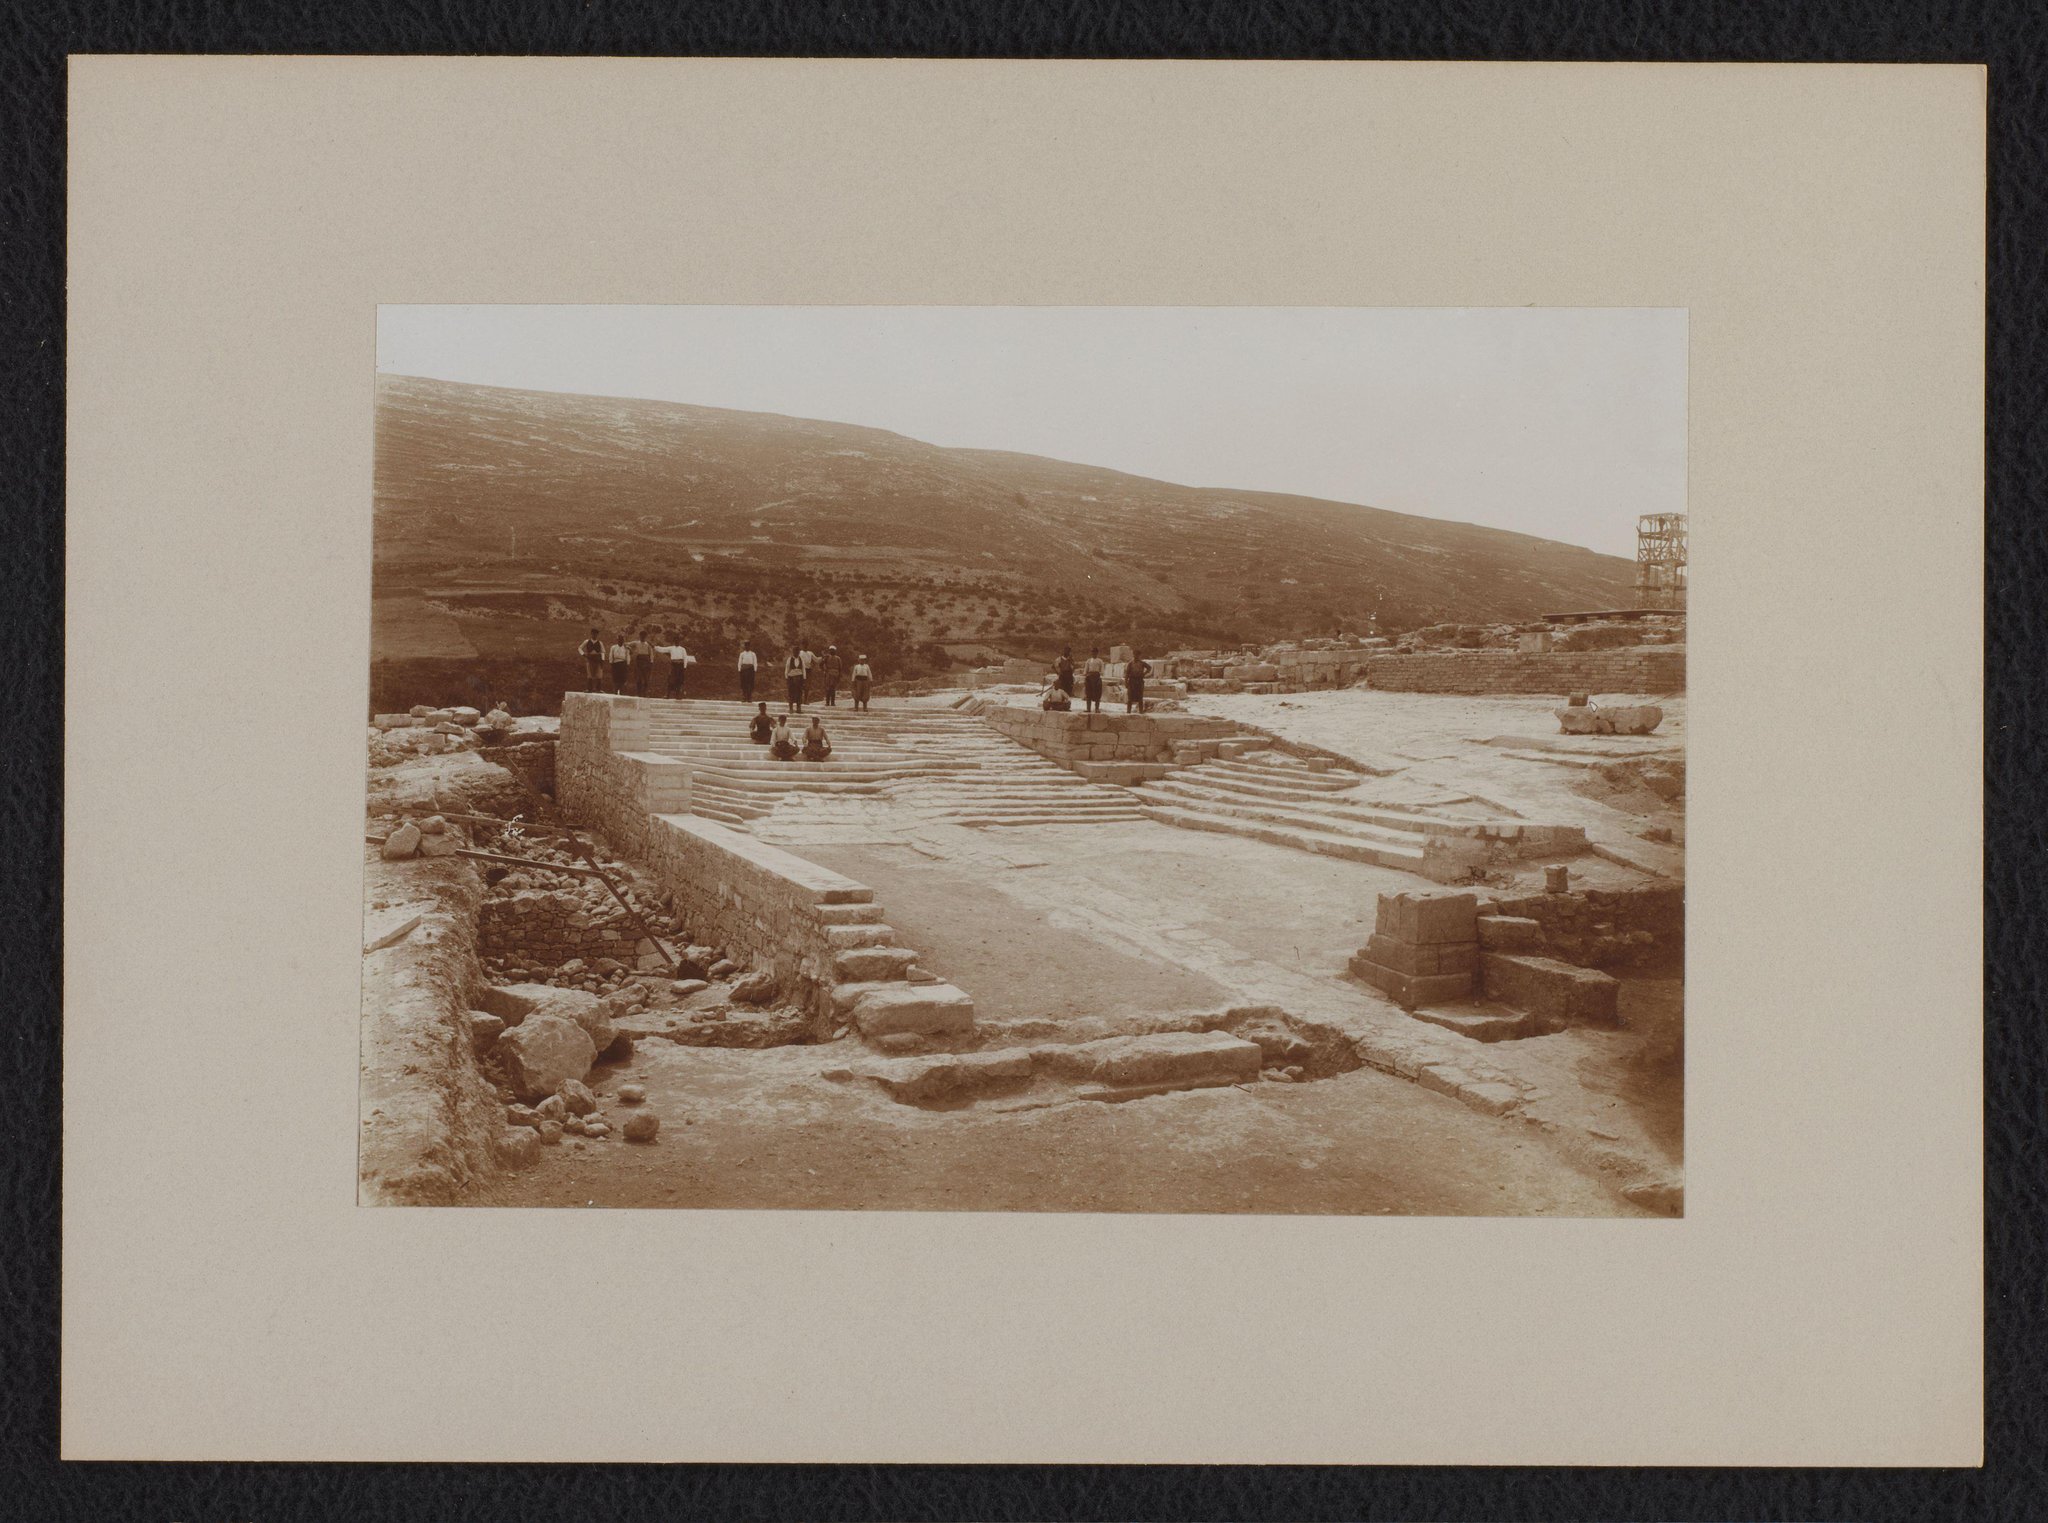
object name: photograph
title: Paleis van Knossos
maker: Anonymous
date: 1895-1915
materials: cardboard, paper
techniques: gelatin silver print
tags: knossós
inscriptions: annotation: ‘50. Kreta; paleis van Cnossos.’